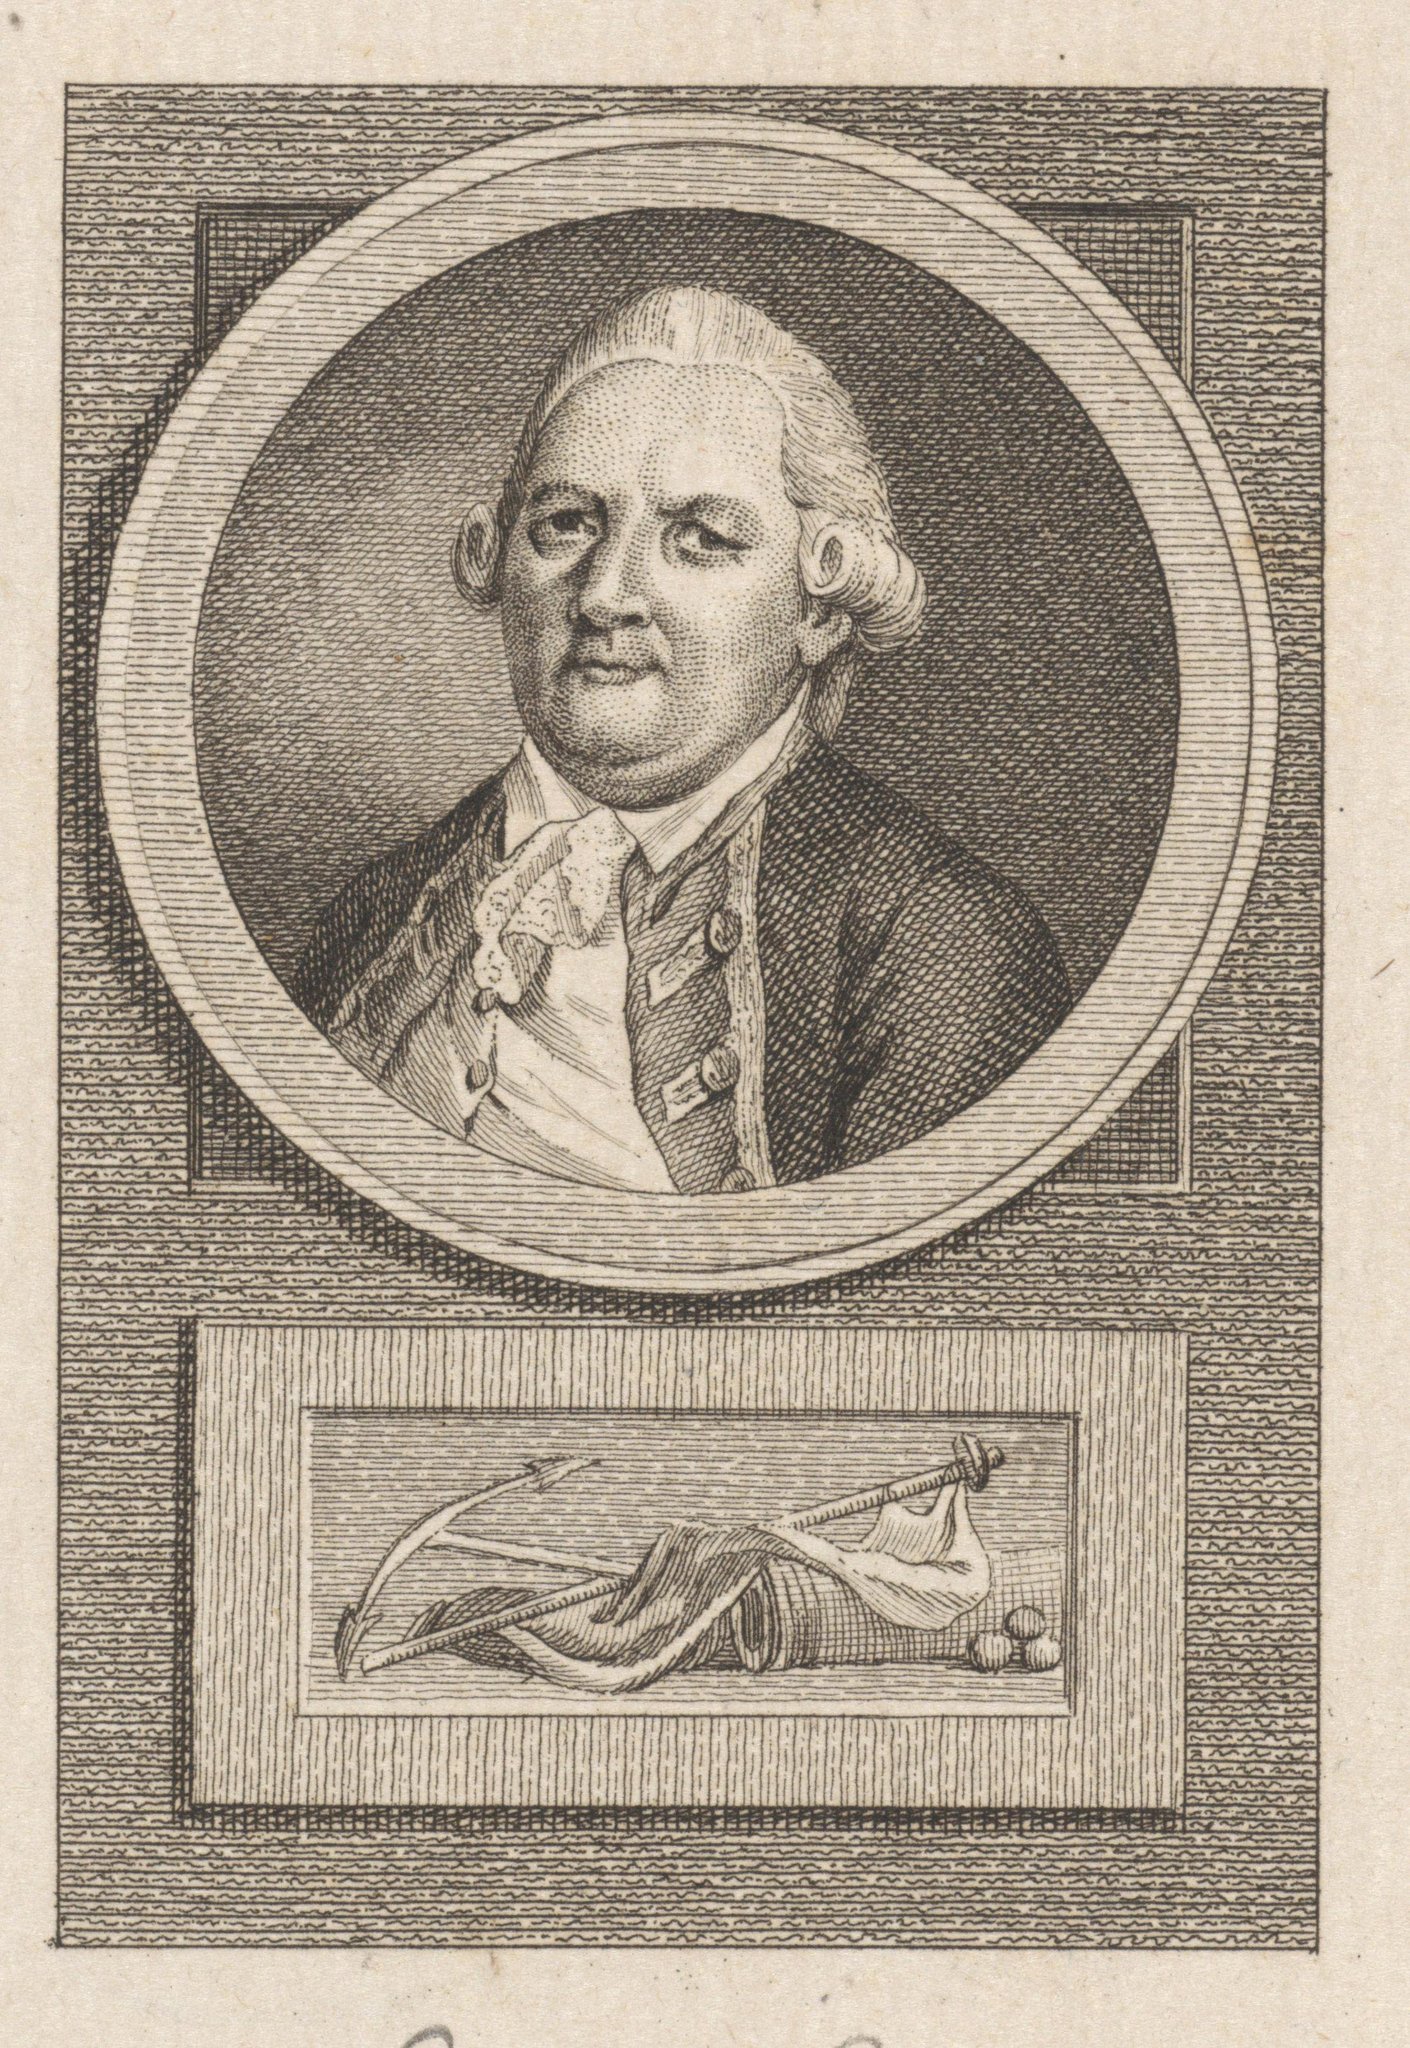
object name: print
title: Portret van Jacob Pieter van Braam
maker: reinier vinkeles (i)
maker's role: draughtsman, print maker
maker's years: 1741-1816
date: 1783-1795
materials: paper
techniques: engraving, etching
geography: amsterdam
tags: firearms: cannon, parts of ship's exterior: anchor, (military) flags and standards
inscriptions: inscription: ‘JP van Braam XXI 175’, collector's mark: Lugt 2228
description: Latere staat prent gebruikt in: Fokke, Jan. Geschiedenissen der Vereenigde Nederlanden voor de vaderlandsche jeugd Ie-XXVste deel. Amsterdam: Johannes Allart, 1783-1795. Deel XXI.